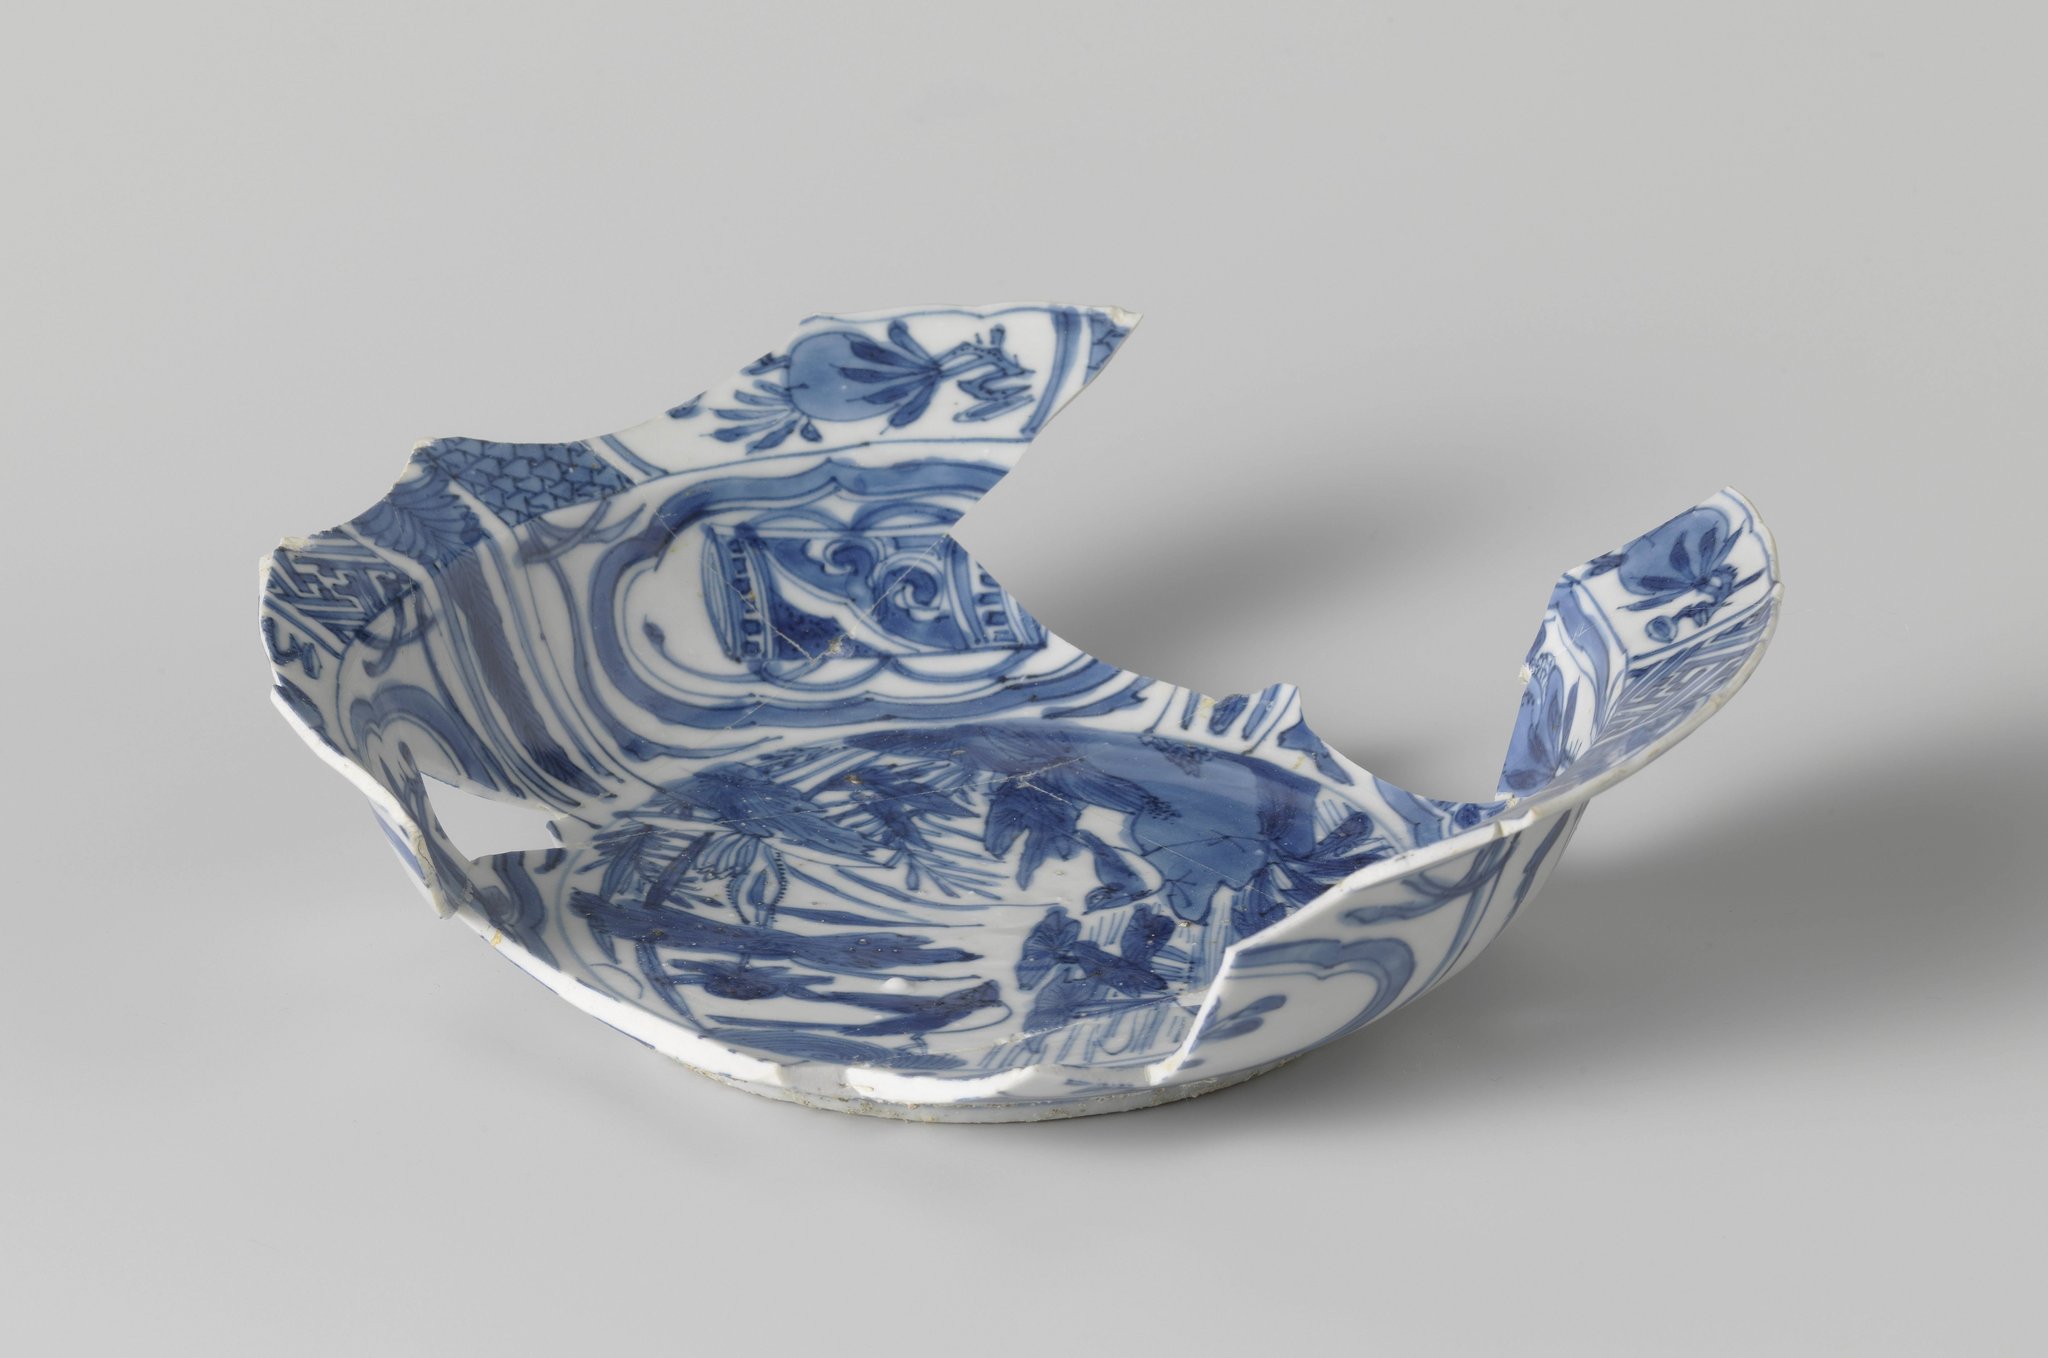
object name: sherd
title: Fragment diep bord uit V.O.C.-schip de 'Witte Leeuw'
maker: Anonymous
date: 1613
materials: bone china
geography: jingdezhen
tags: verenigde oostindische compagnie, sint-helena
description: A bowl with a flattened rim. Cartouches with fruits enclosed by diaper patterns. A central decoration of birds and a lotus. Panels decorated with fruits and symbols.